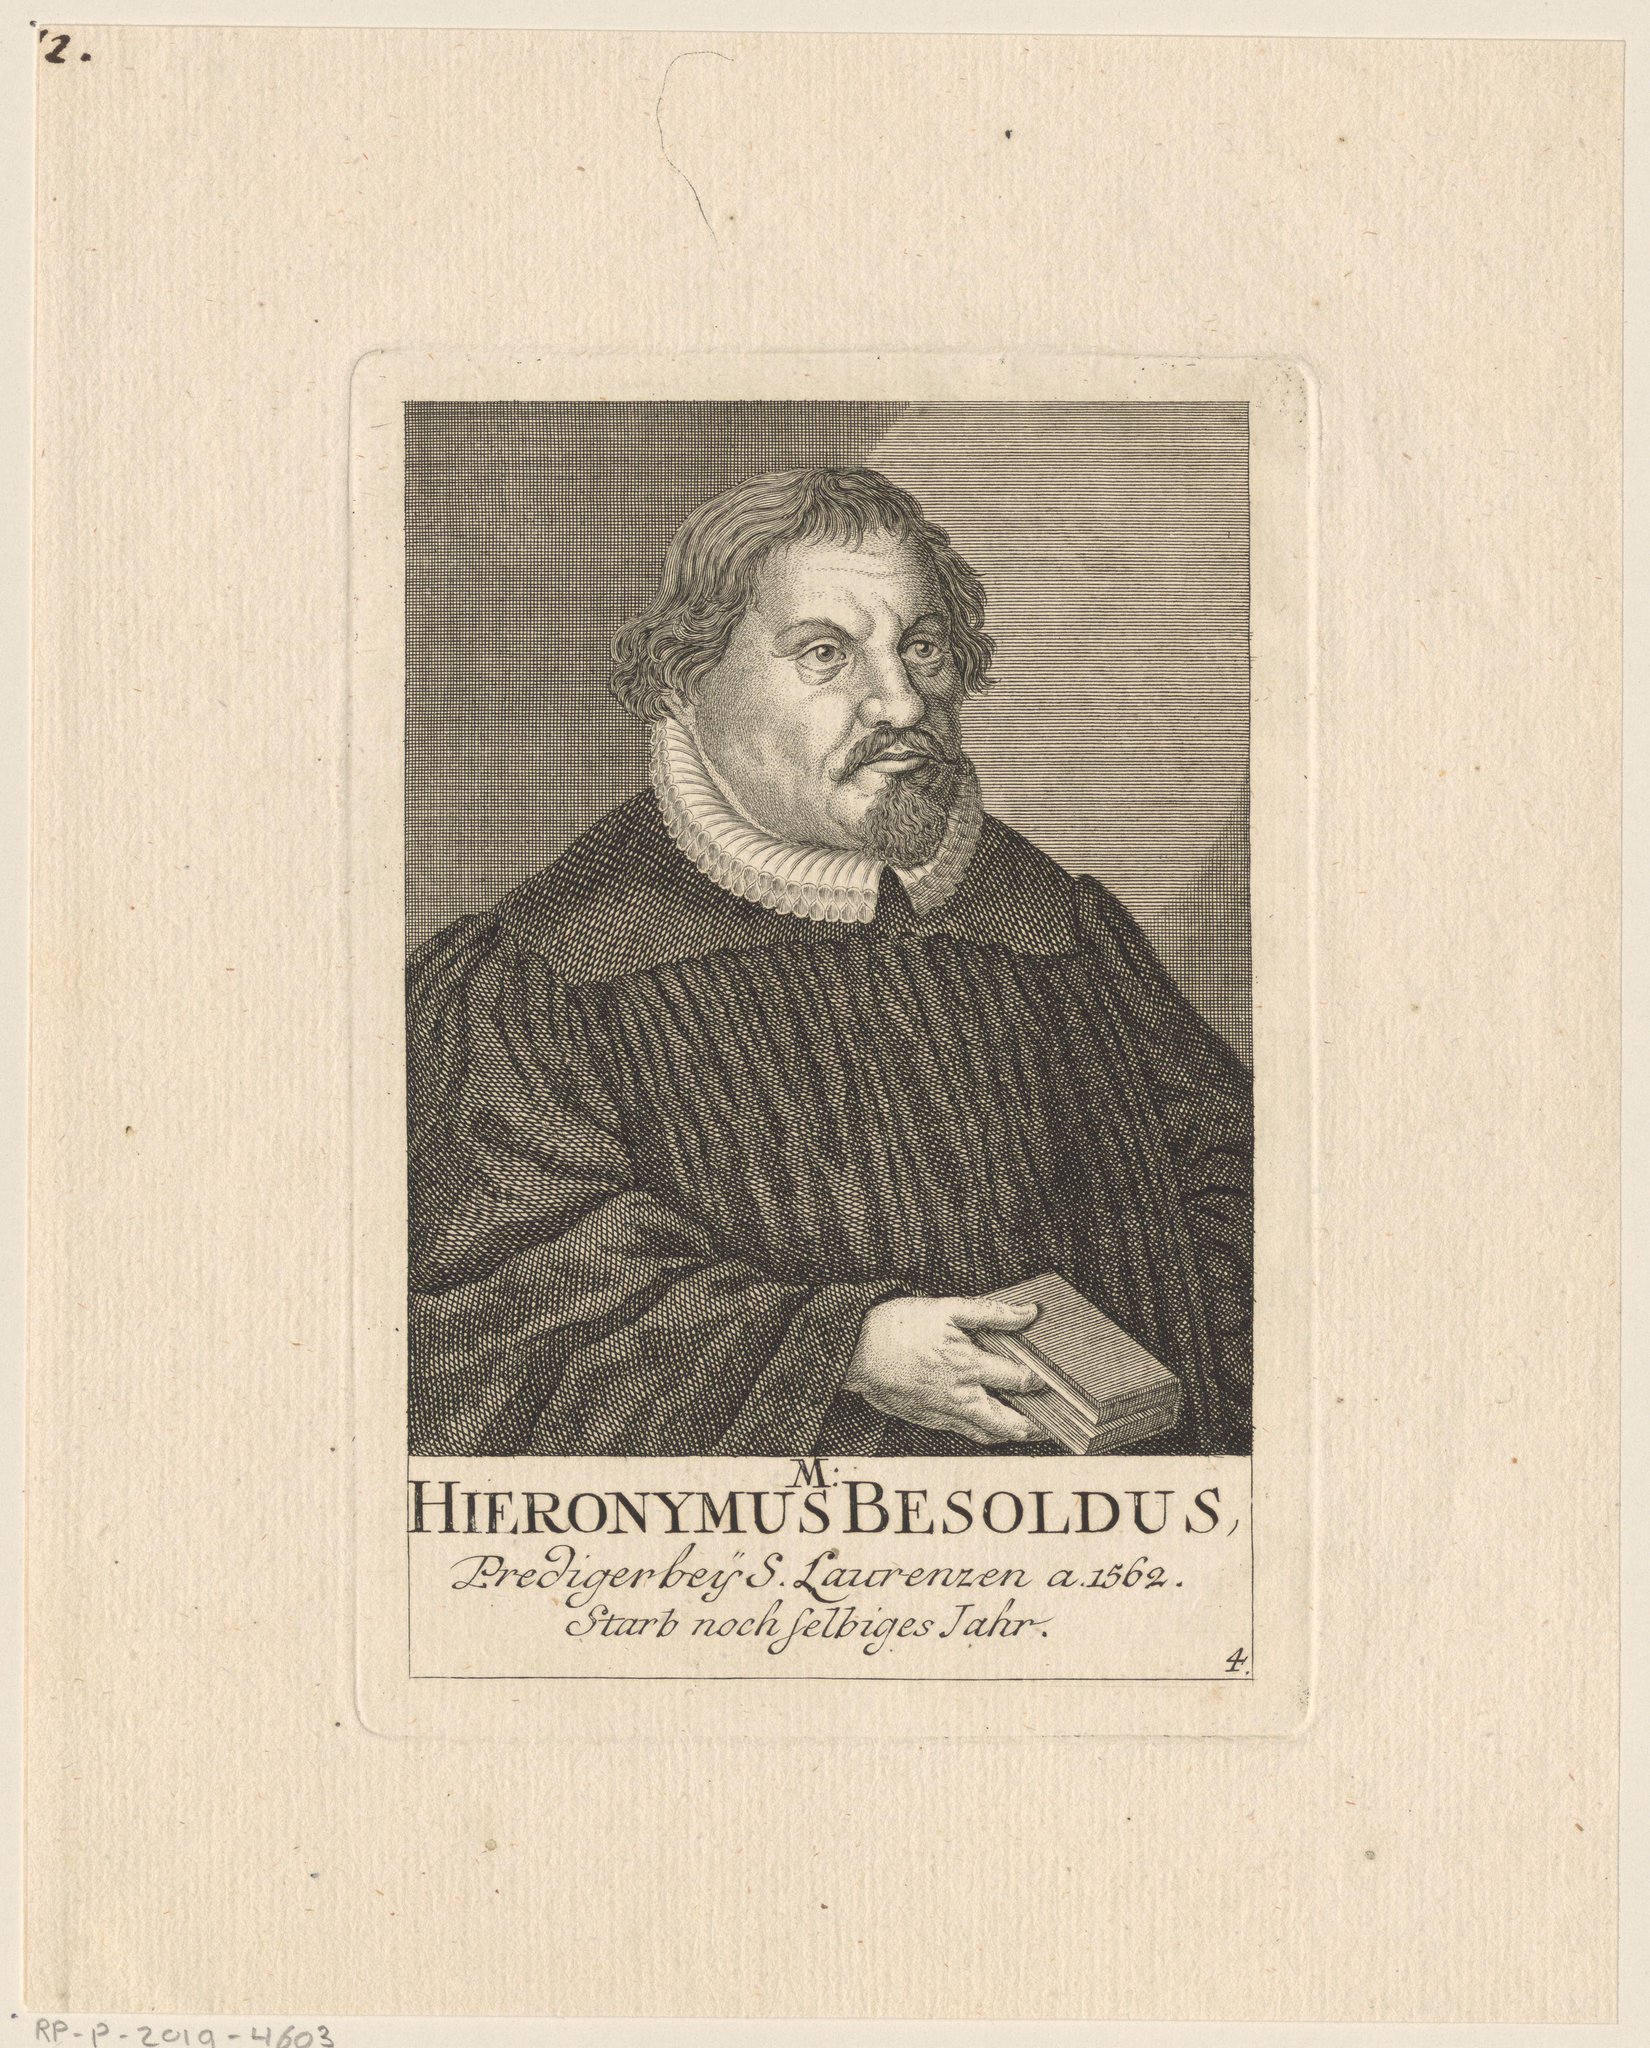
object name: print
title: Portret van Hieronymus Besold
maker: Anonymous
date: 1700-1749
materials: paper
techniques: engraving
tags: theologian, historical persons, book